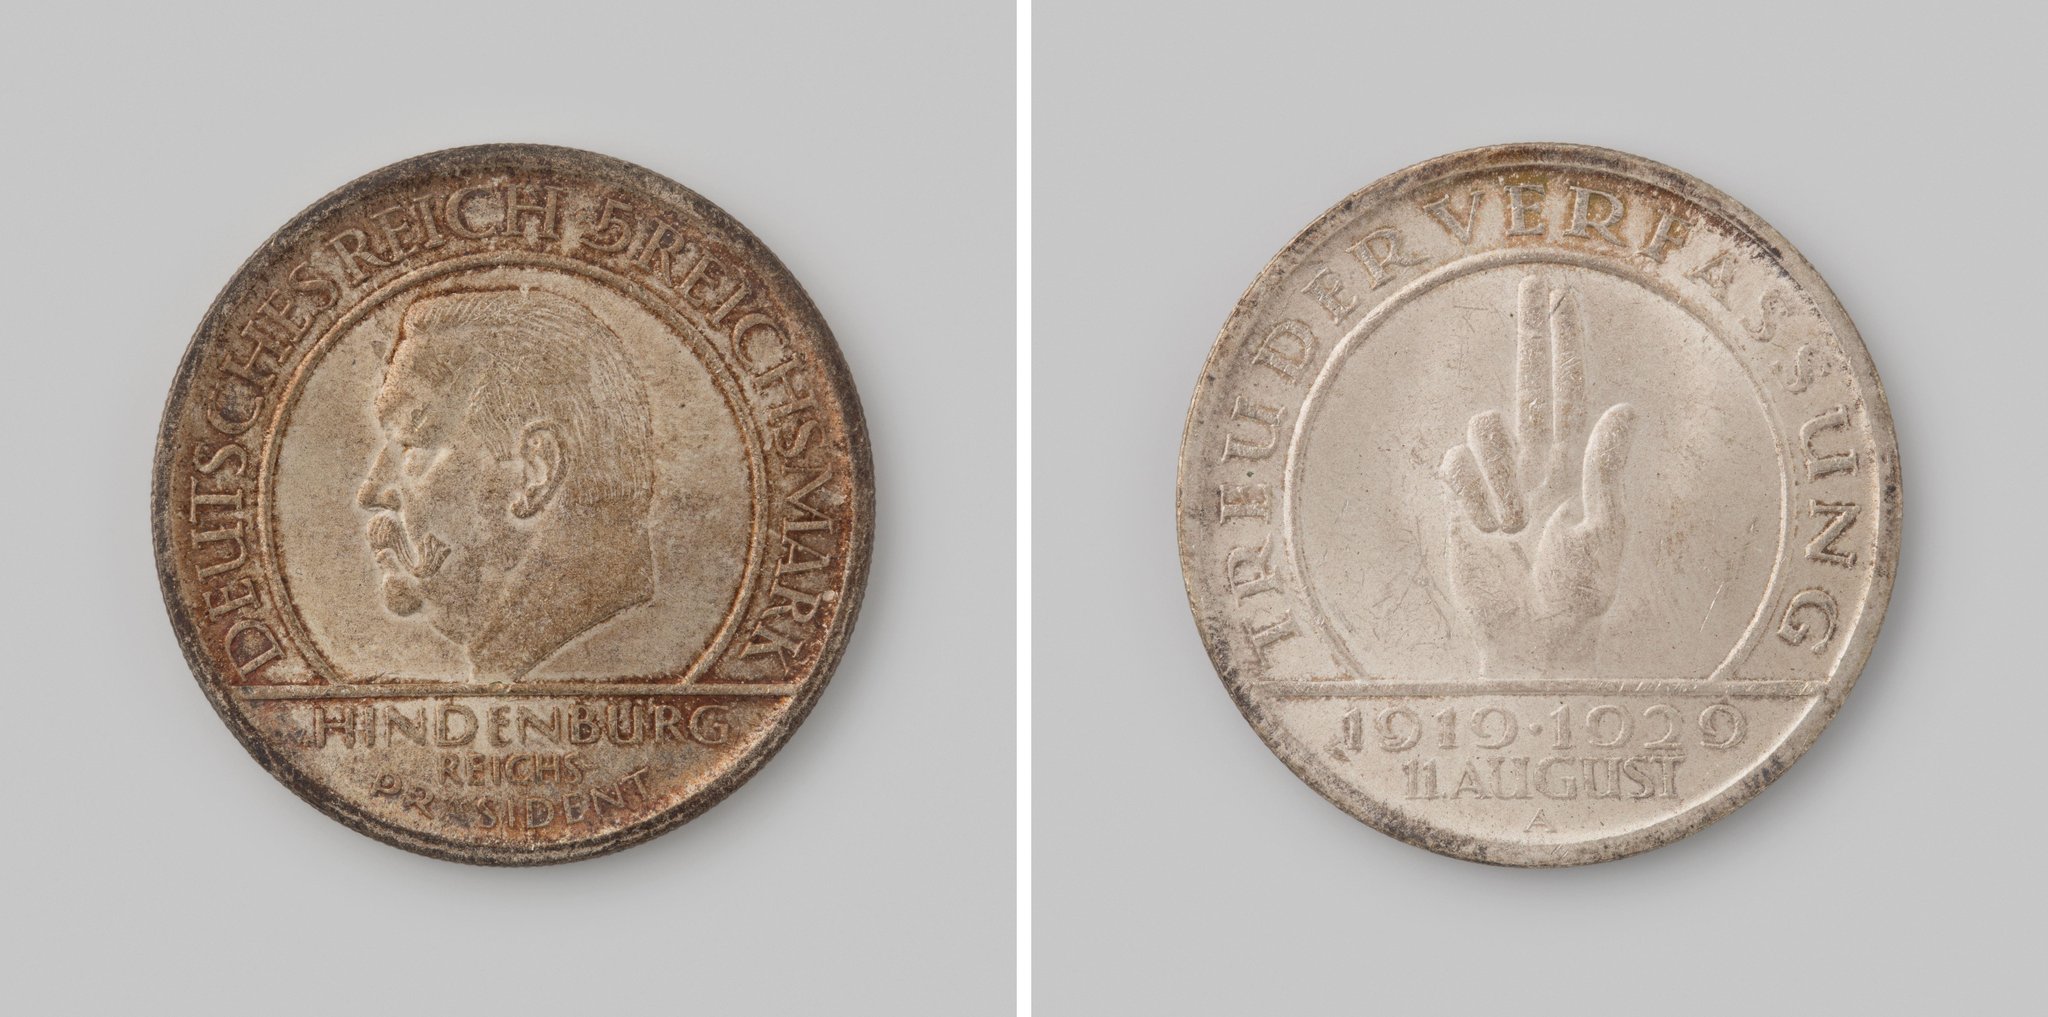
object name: coin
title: Duitsland, 5 Reichsmark, 1929 A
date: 1929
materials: silver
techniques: striking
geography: berlin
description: Zilveren herdenkingsmunt van het 10-jarig bestaan van de Grondwet. Voorzijde: hoofd van Hindenburg naar links. Waarde-aanduiding in omschrift. Keerzijde: eed afleggende hand. In afsnede data 11. August 1919-1929. Daaronder letter A. Kartelrand.